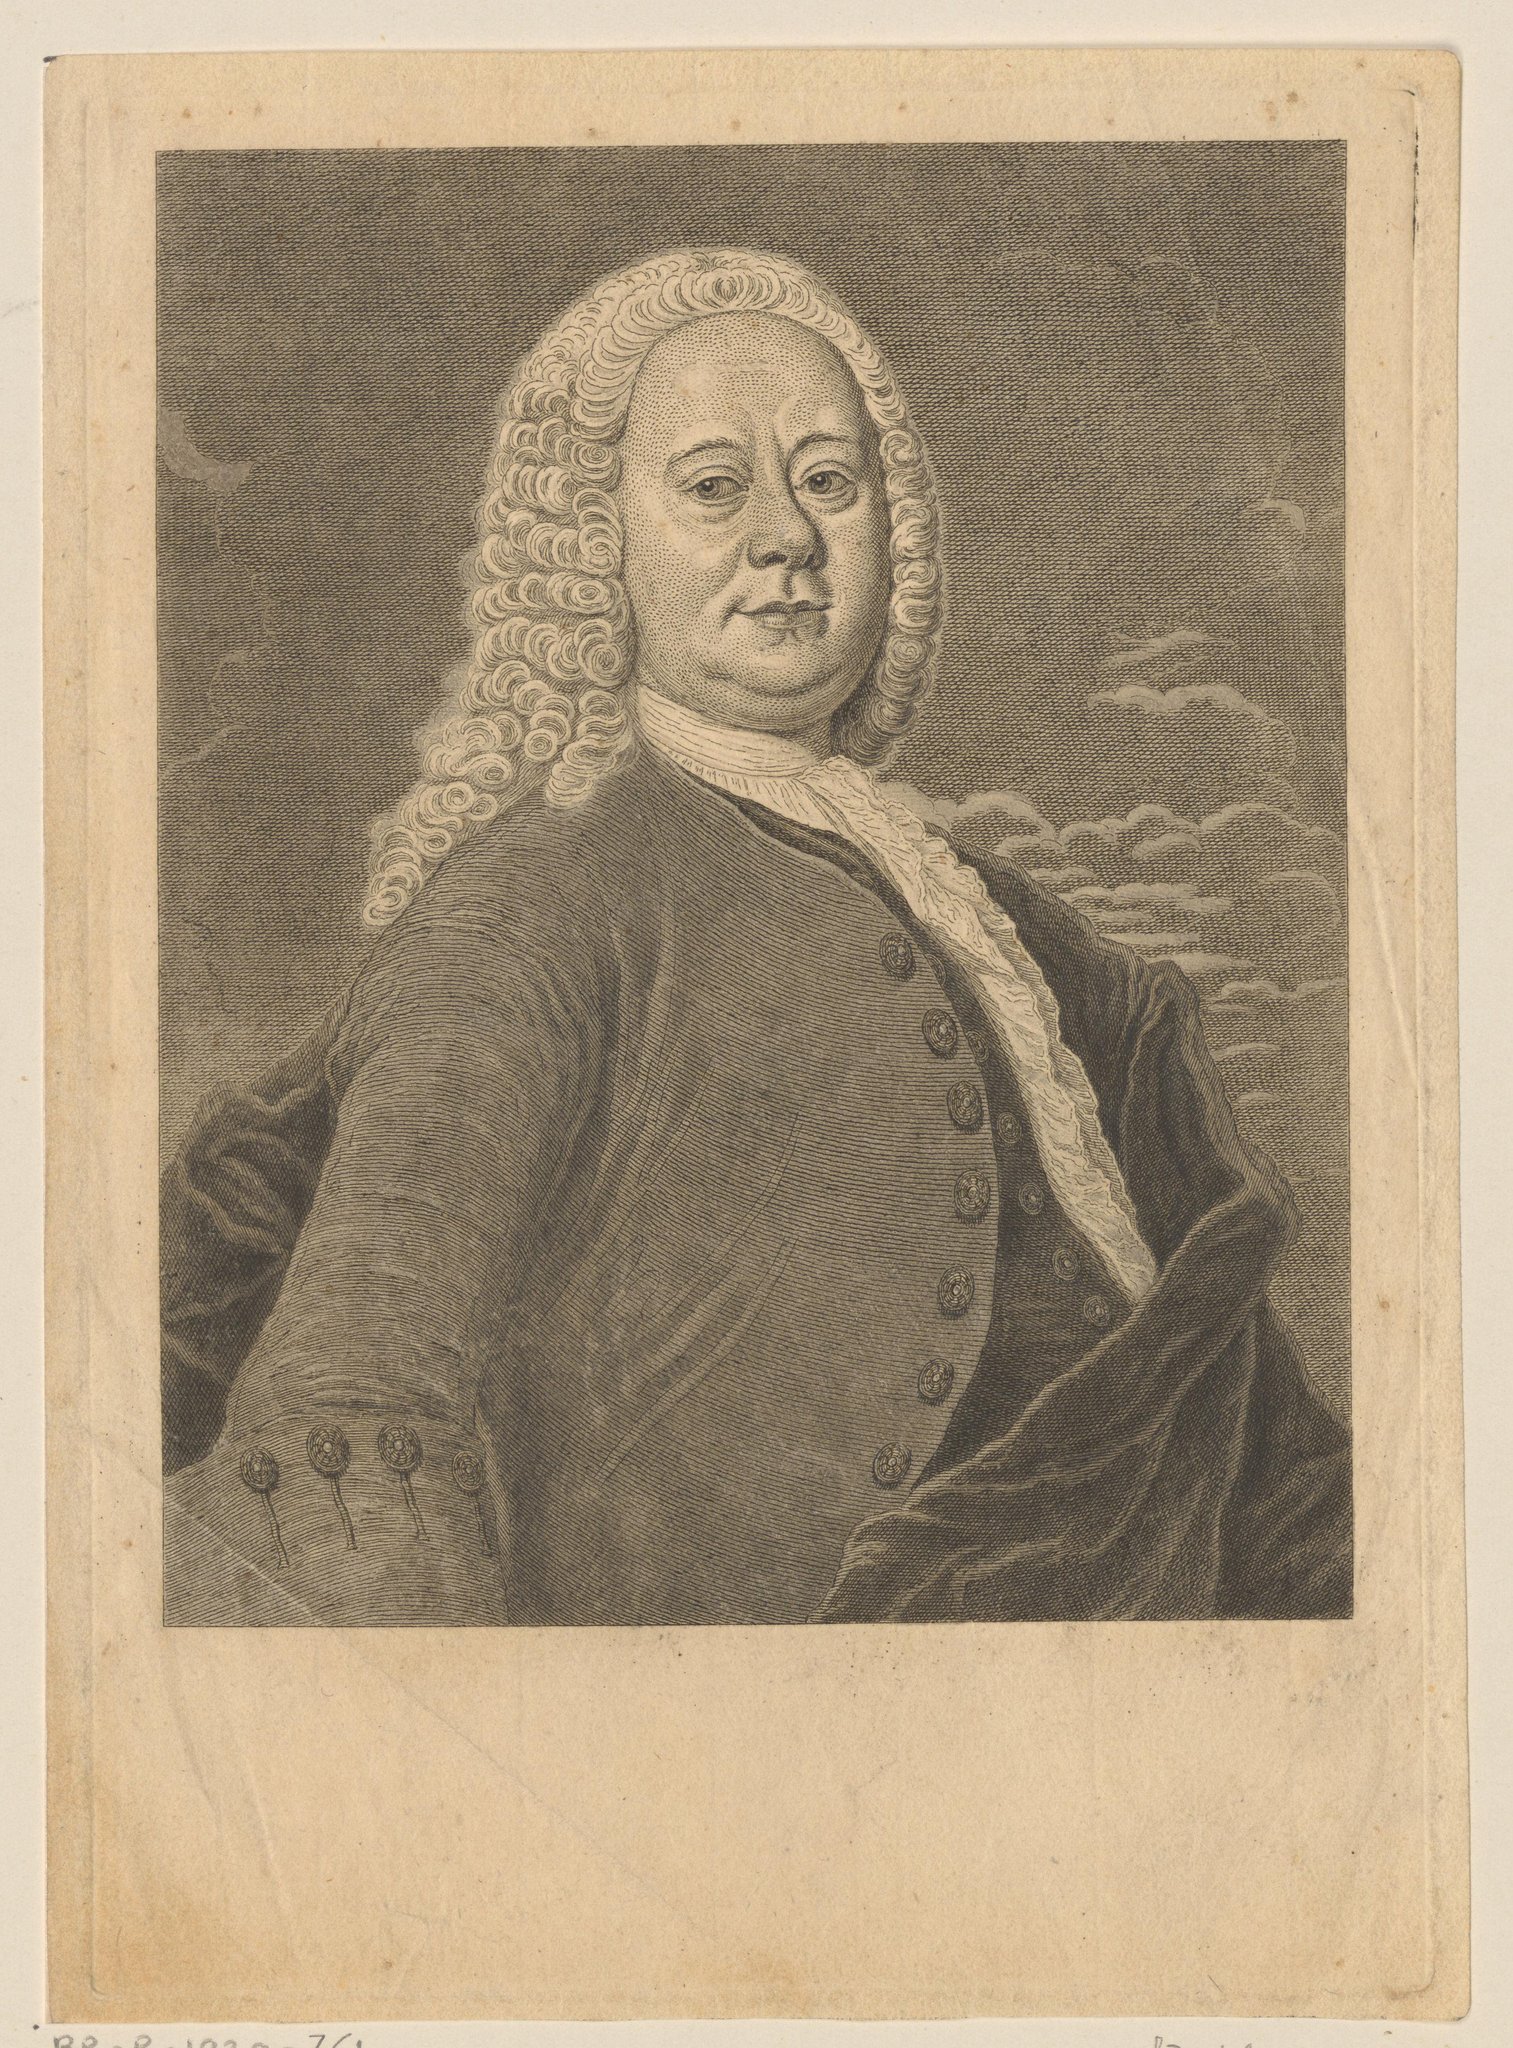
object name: print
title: Portret van Jobst Heinrich Hansen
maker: Anonymous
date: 1750-1799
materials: ink, paper, pencil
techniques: brush, etching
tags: historical persons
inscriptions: collector's mark: Lugt 2228